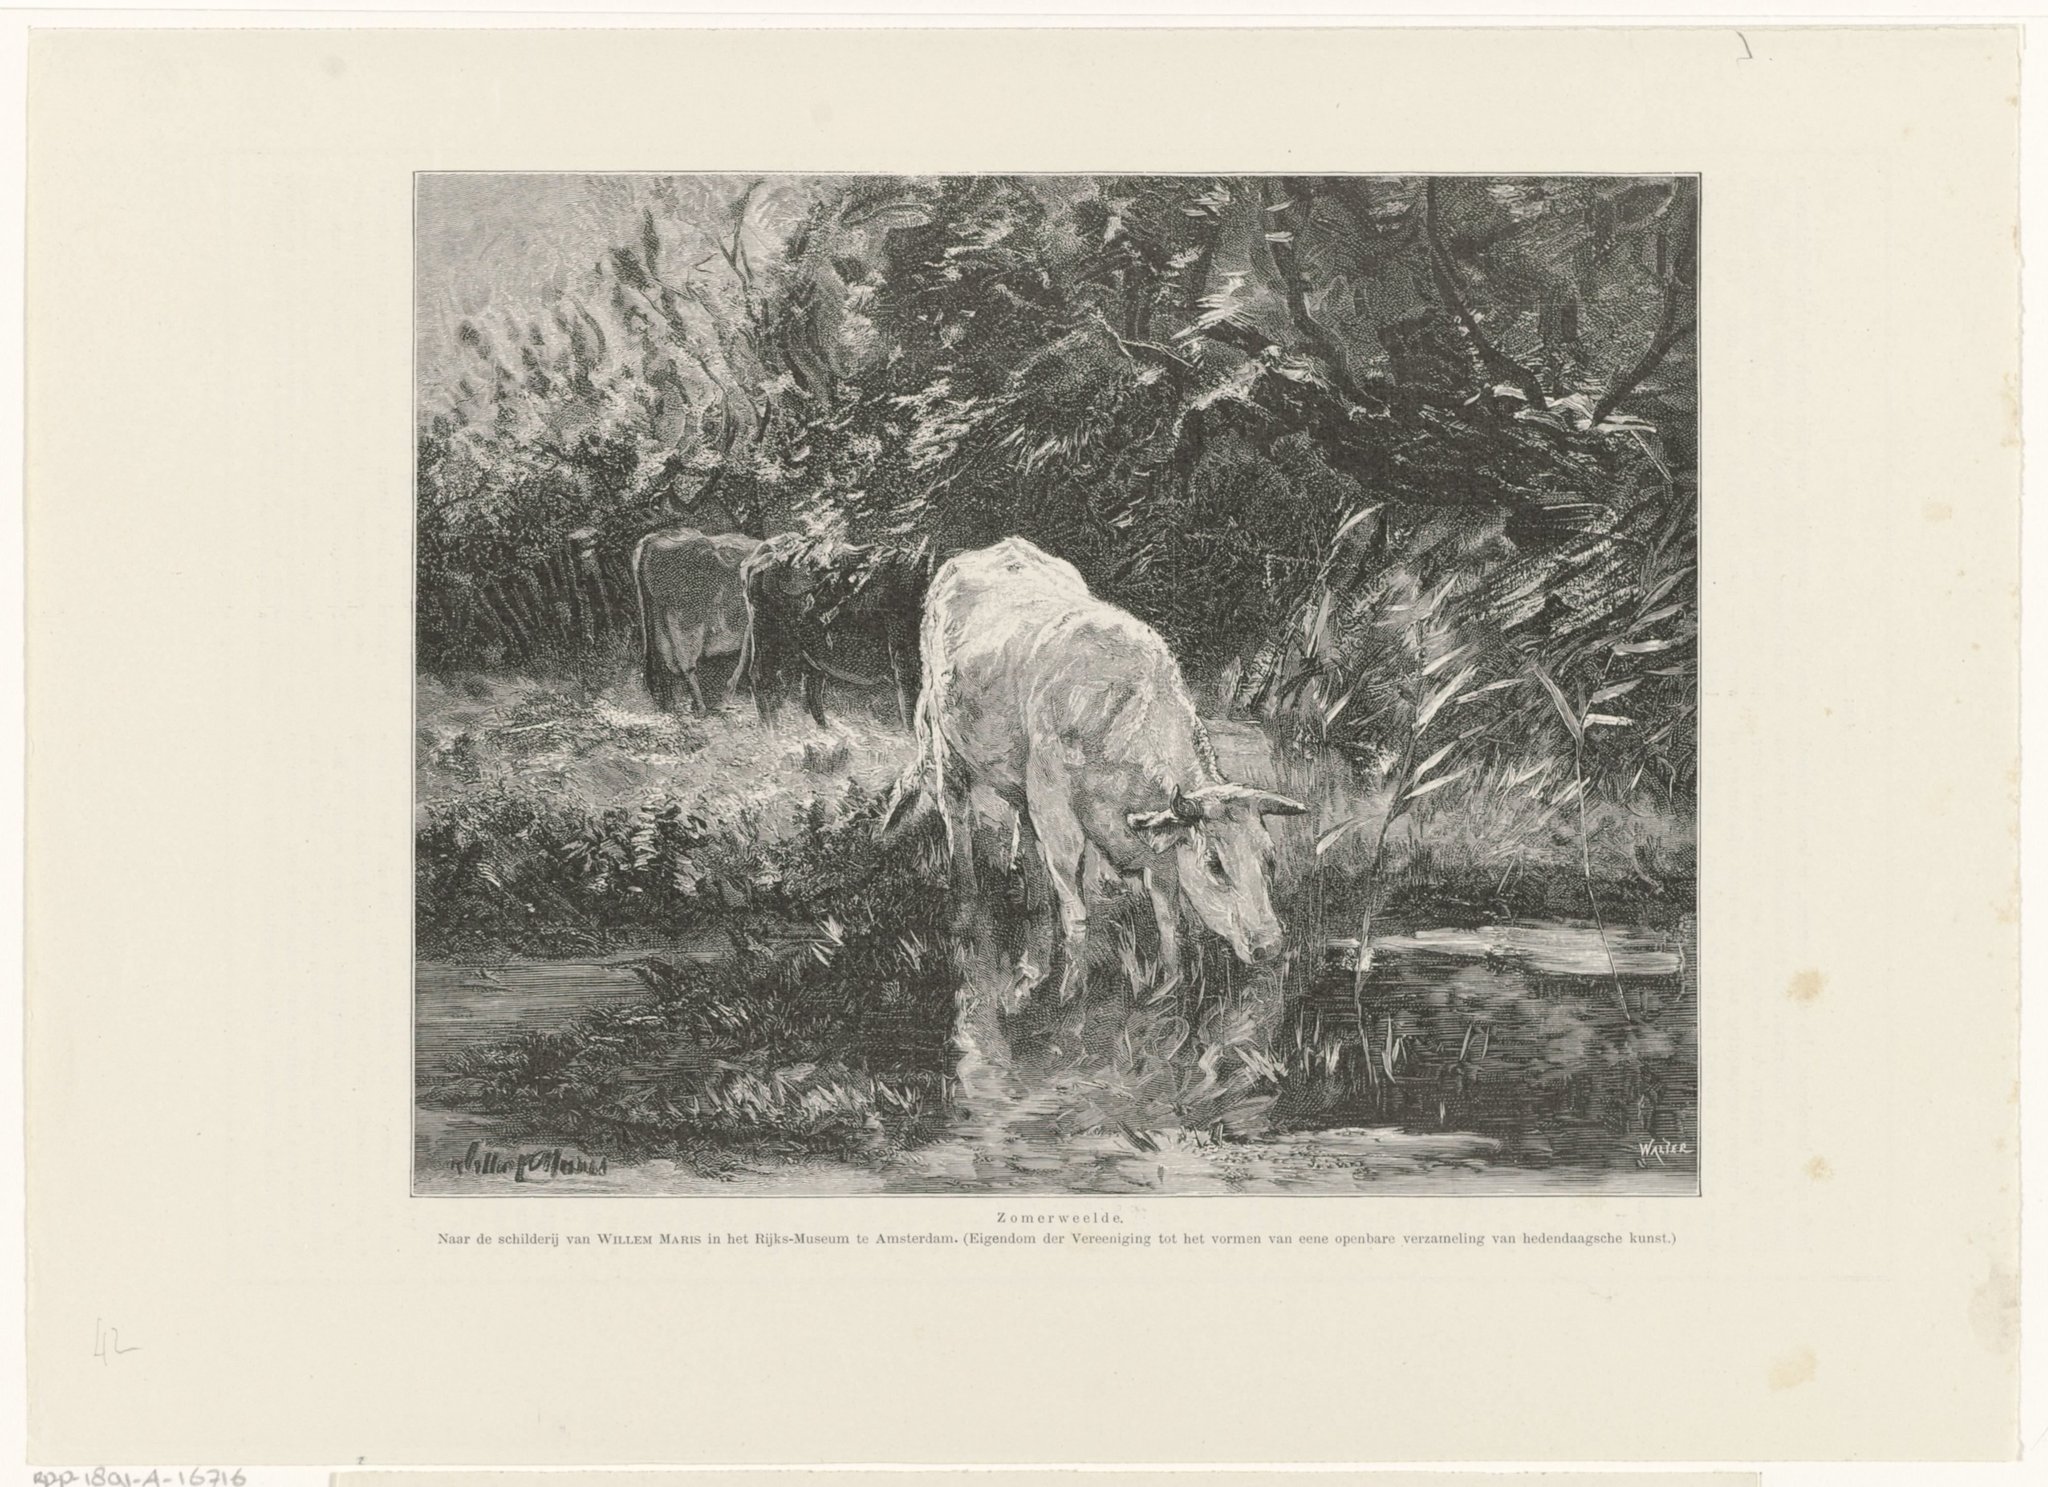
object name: book illustration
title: Zomerweelde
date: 1849-1891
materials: paper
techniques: letterpress printing, engraving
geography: netherlands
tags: cow, water meadows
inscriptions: collector's mark: Lugt 2228